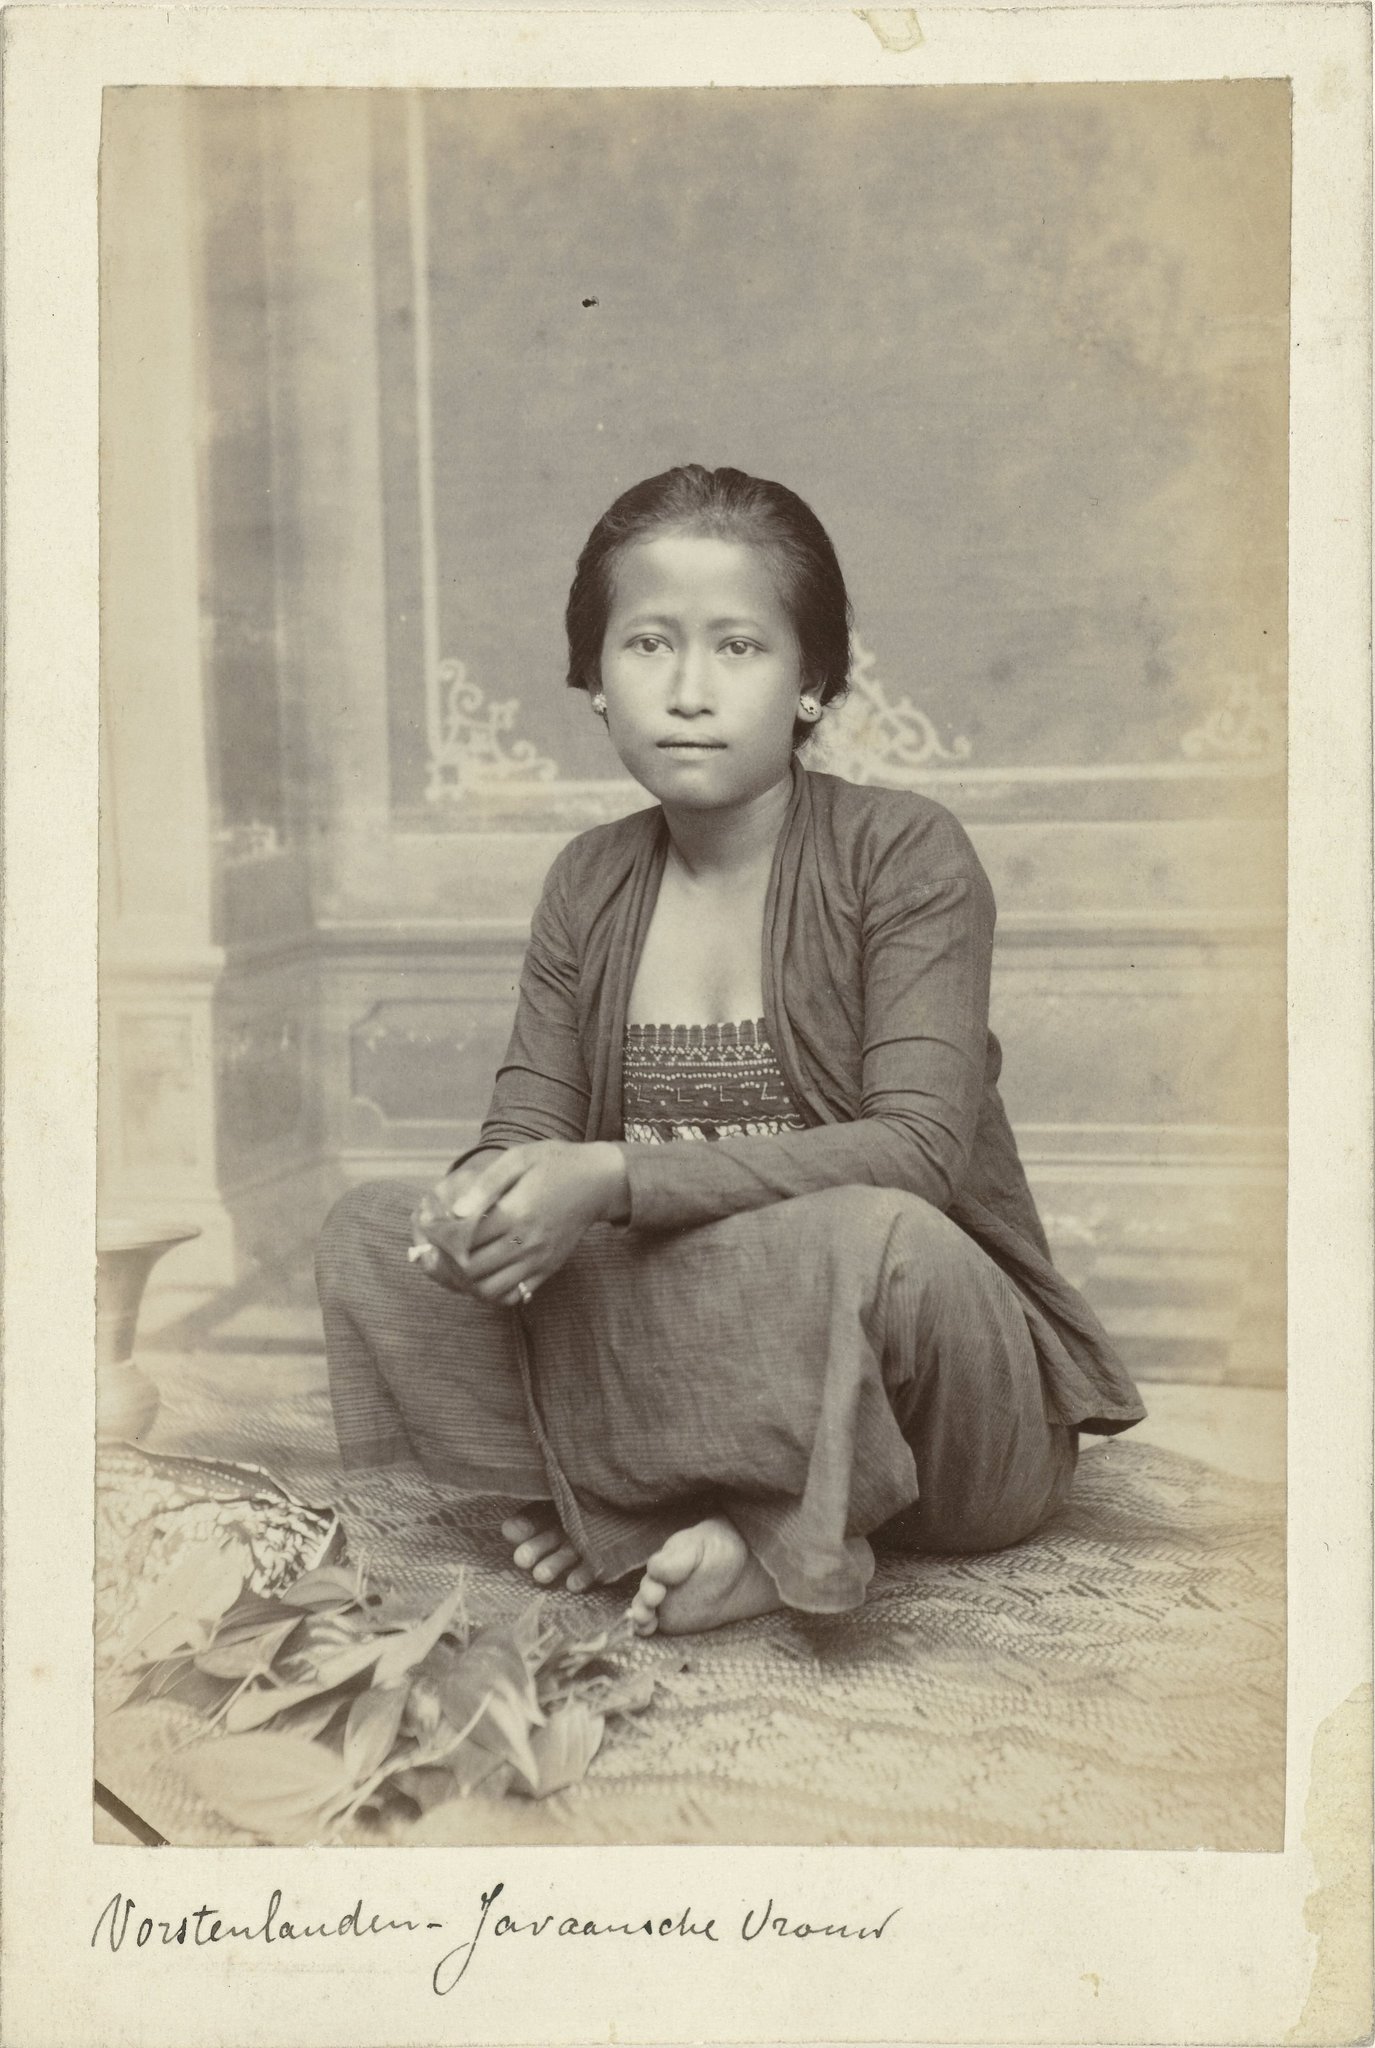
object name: photograph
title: Studioportret van een onbekende Javaanse vrouw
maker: Anonymous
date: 1870-1890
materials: cardboard, paper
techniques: albumen print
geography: indonesia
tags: adult woman, historical persons not known by name - bb - woman, indonesia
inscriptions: number: ‘81’, inscription: ‘Vorstenlanden - Javaansche Vrouw’